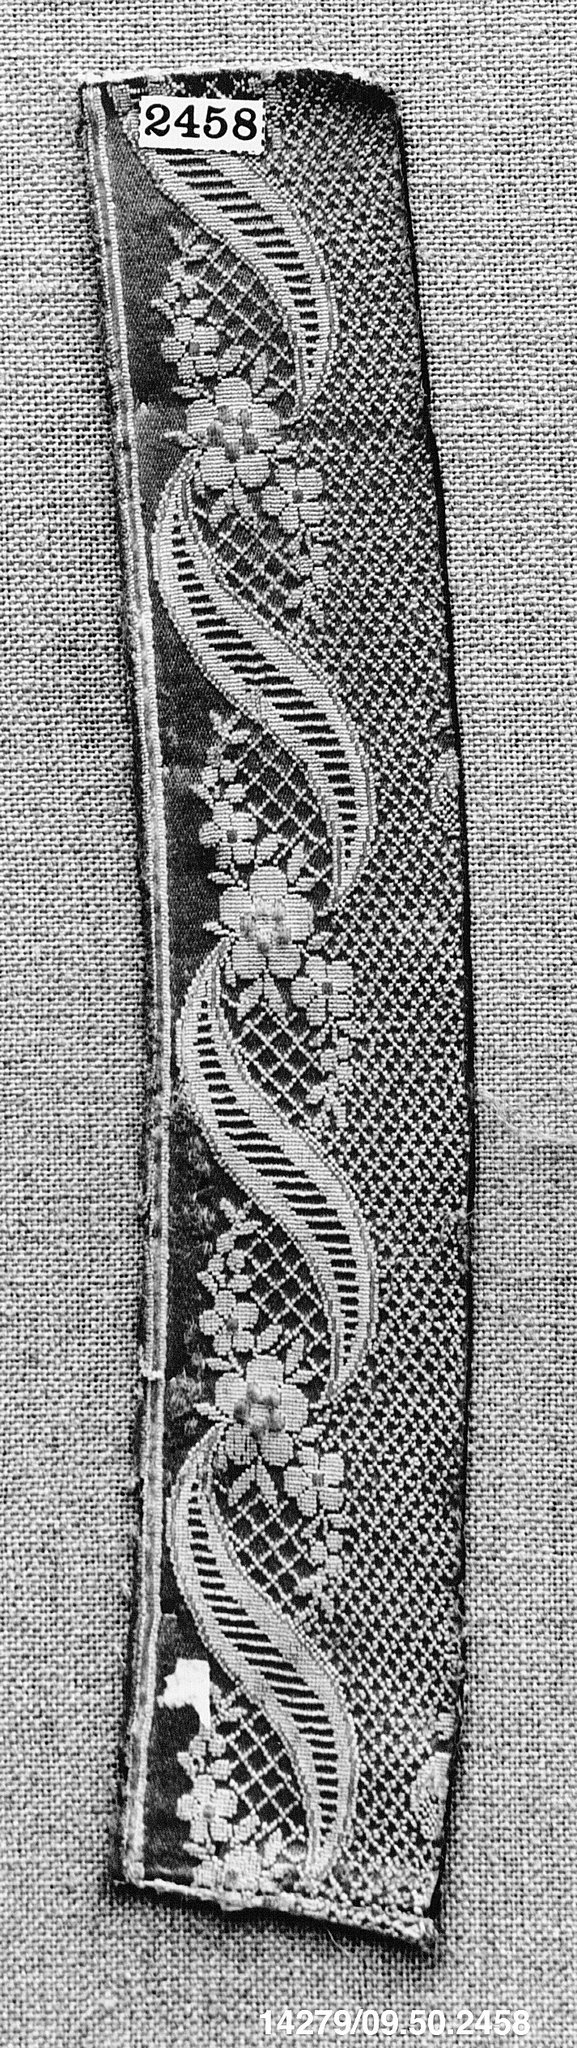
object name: piece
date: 1801-1833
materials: silk